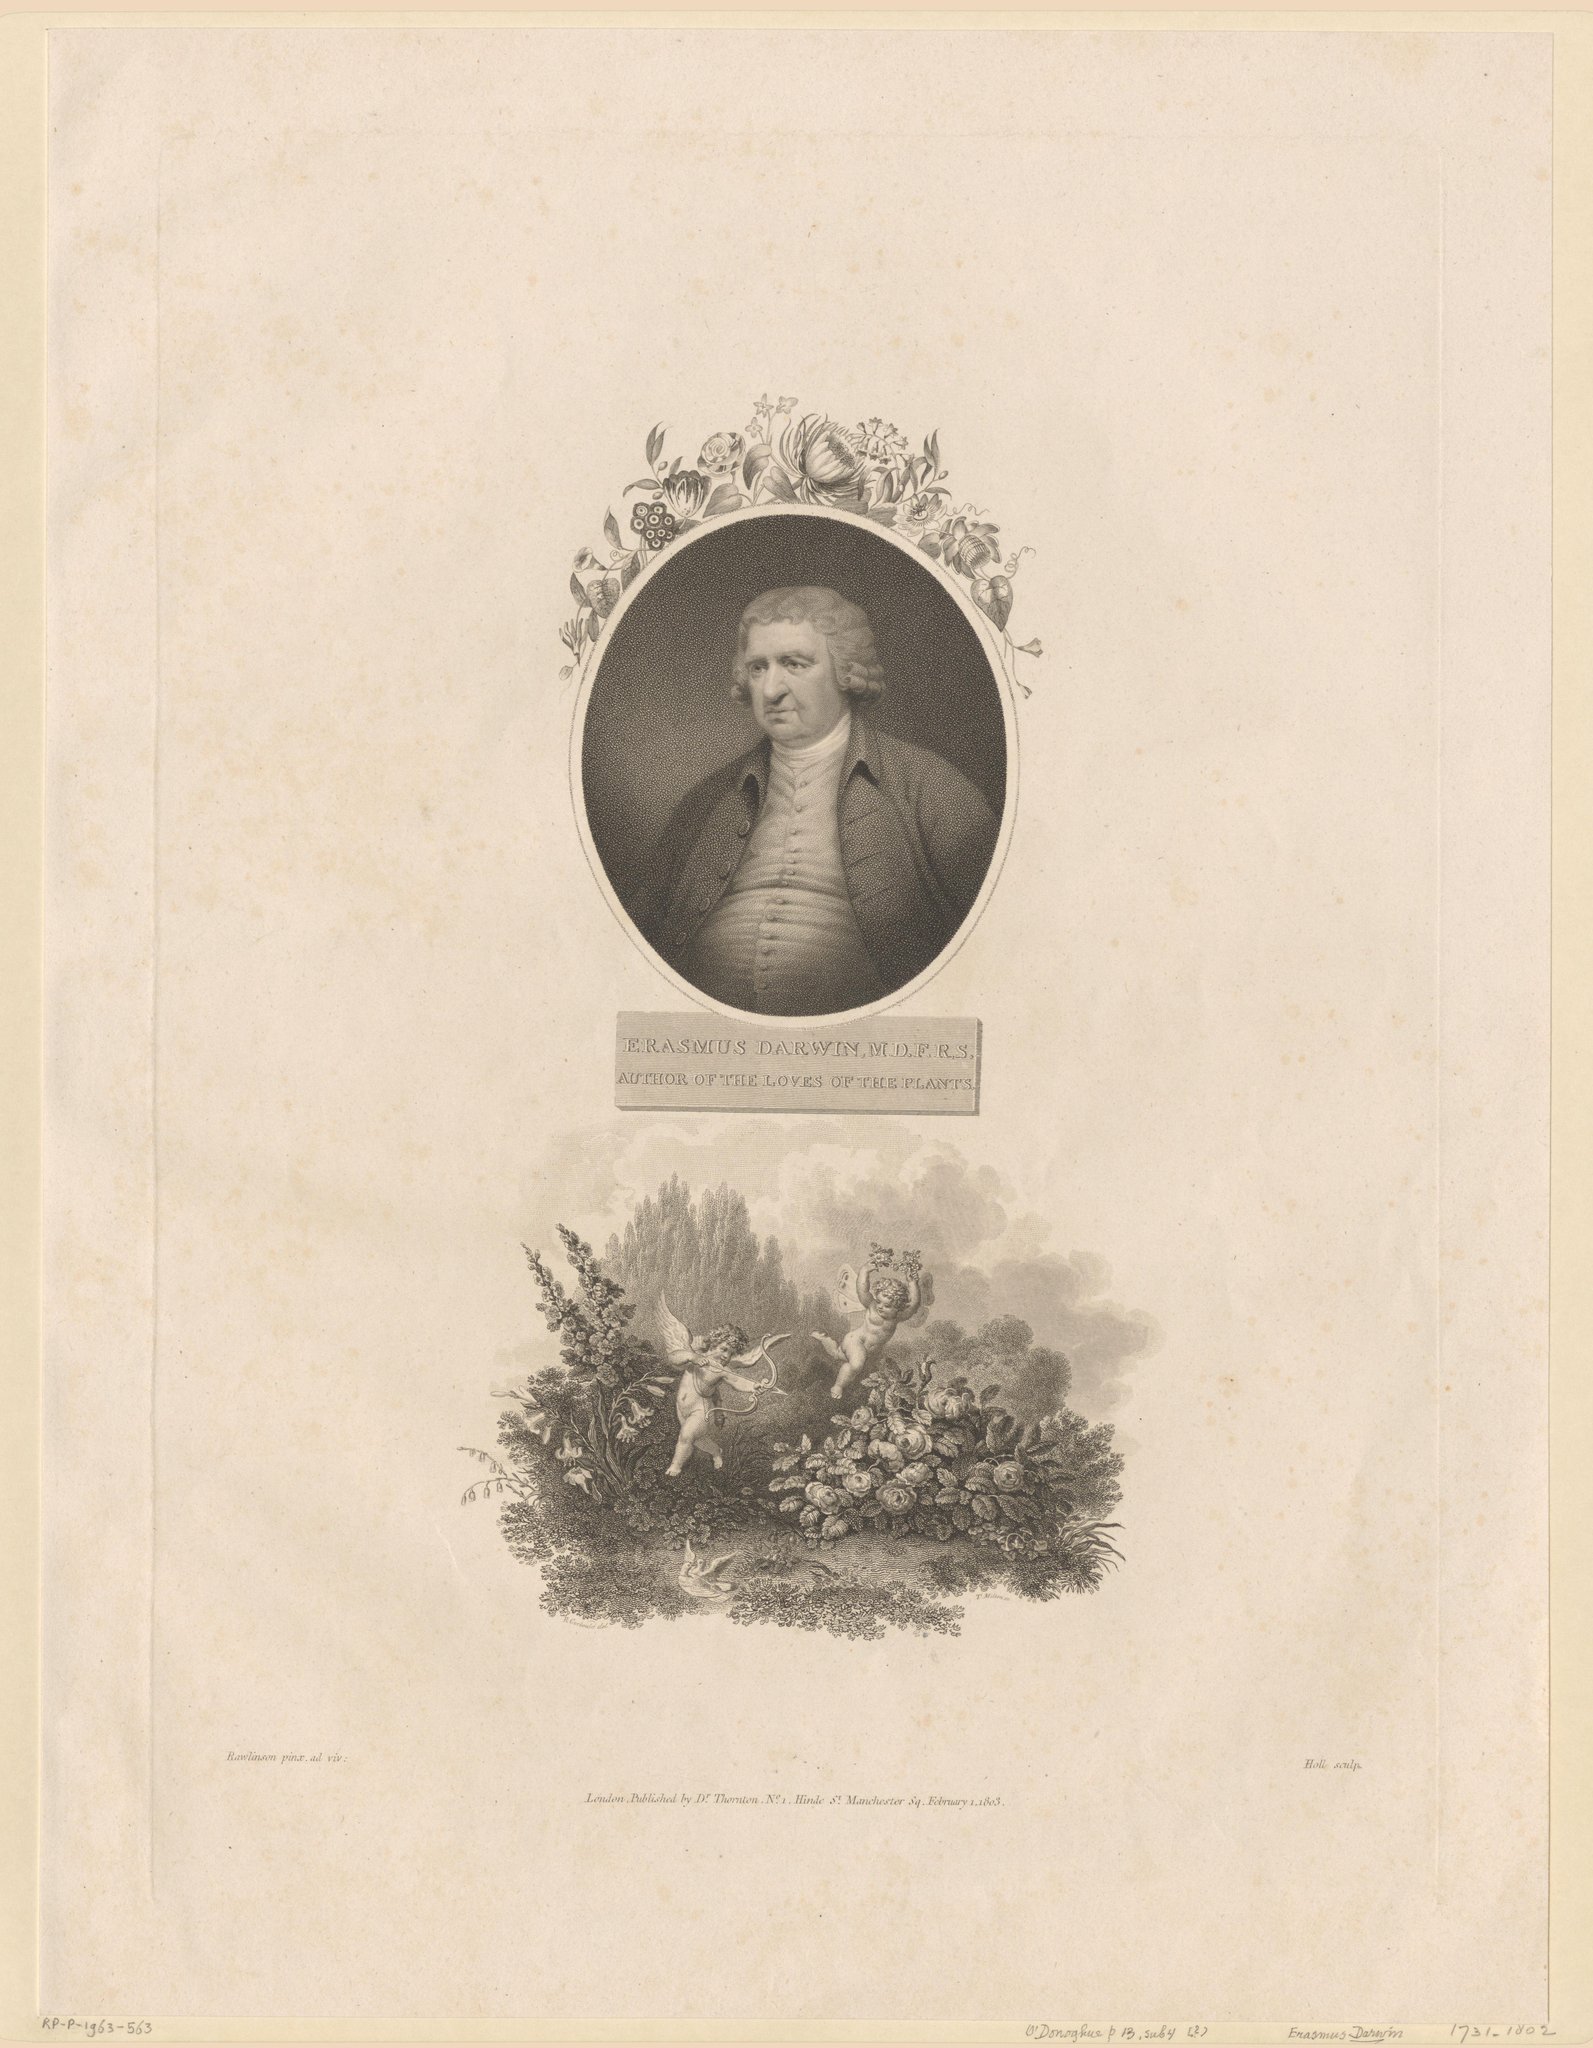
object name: print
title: Portret van Erasmus Darwin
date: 1803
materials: paper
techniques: etching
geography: london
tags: physicist, flowers, other birds: dove, historical persons, physician, doctor, writer, poet, author, cupids: 'amores', 'amoretti', 'putti'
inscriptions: collector's mark: Lugt 2228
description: Prent waarschijnlijk uit: Thornton, Robert John. New Illustration of the Sexual System of Linnaeus (...) and the Temple of Flora (...). Londen: Robert John Thornton, 1803.